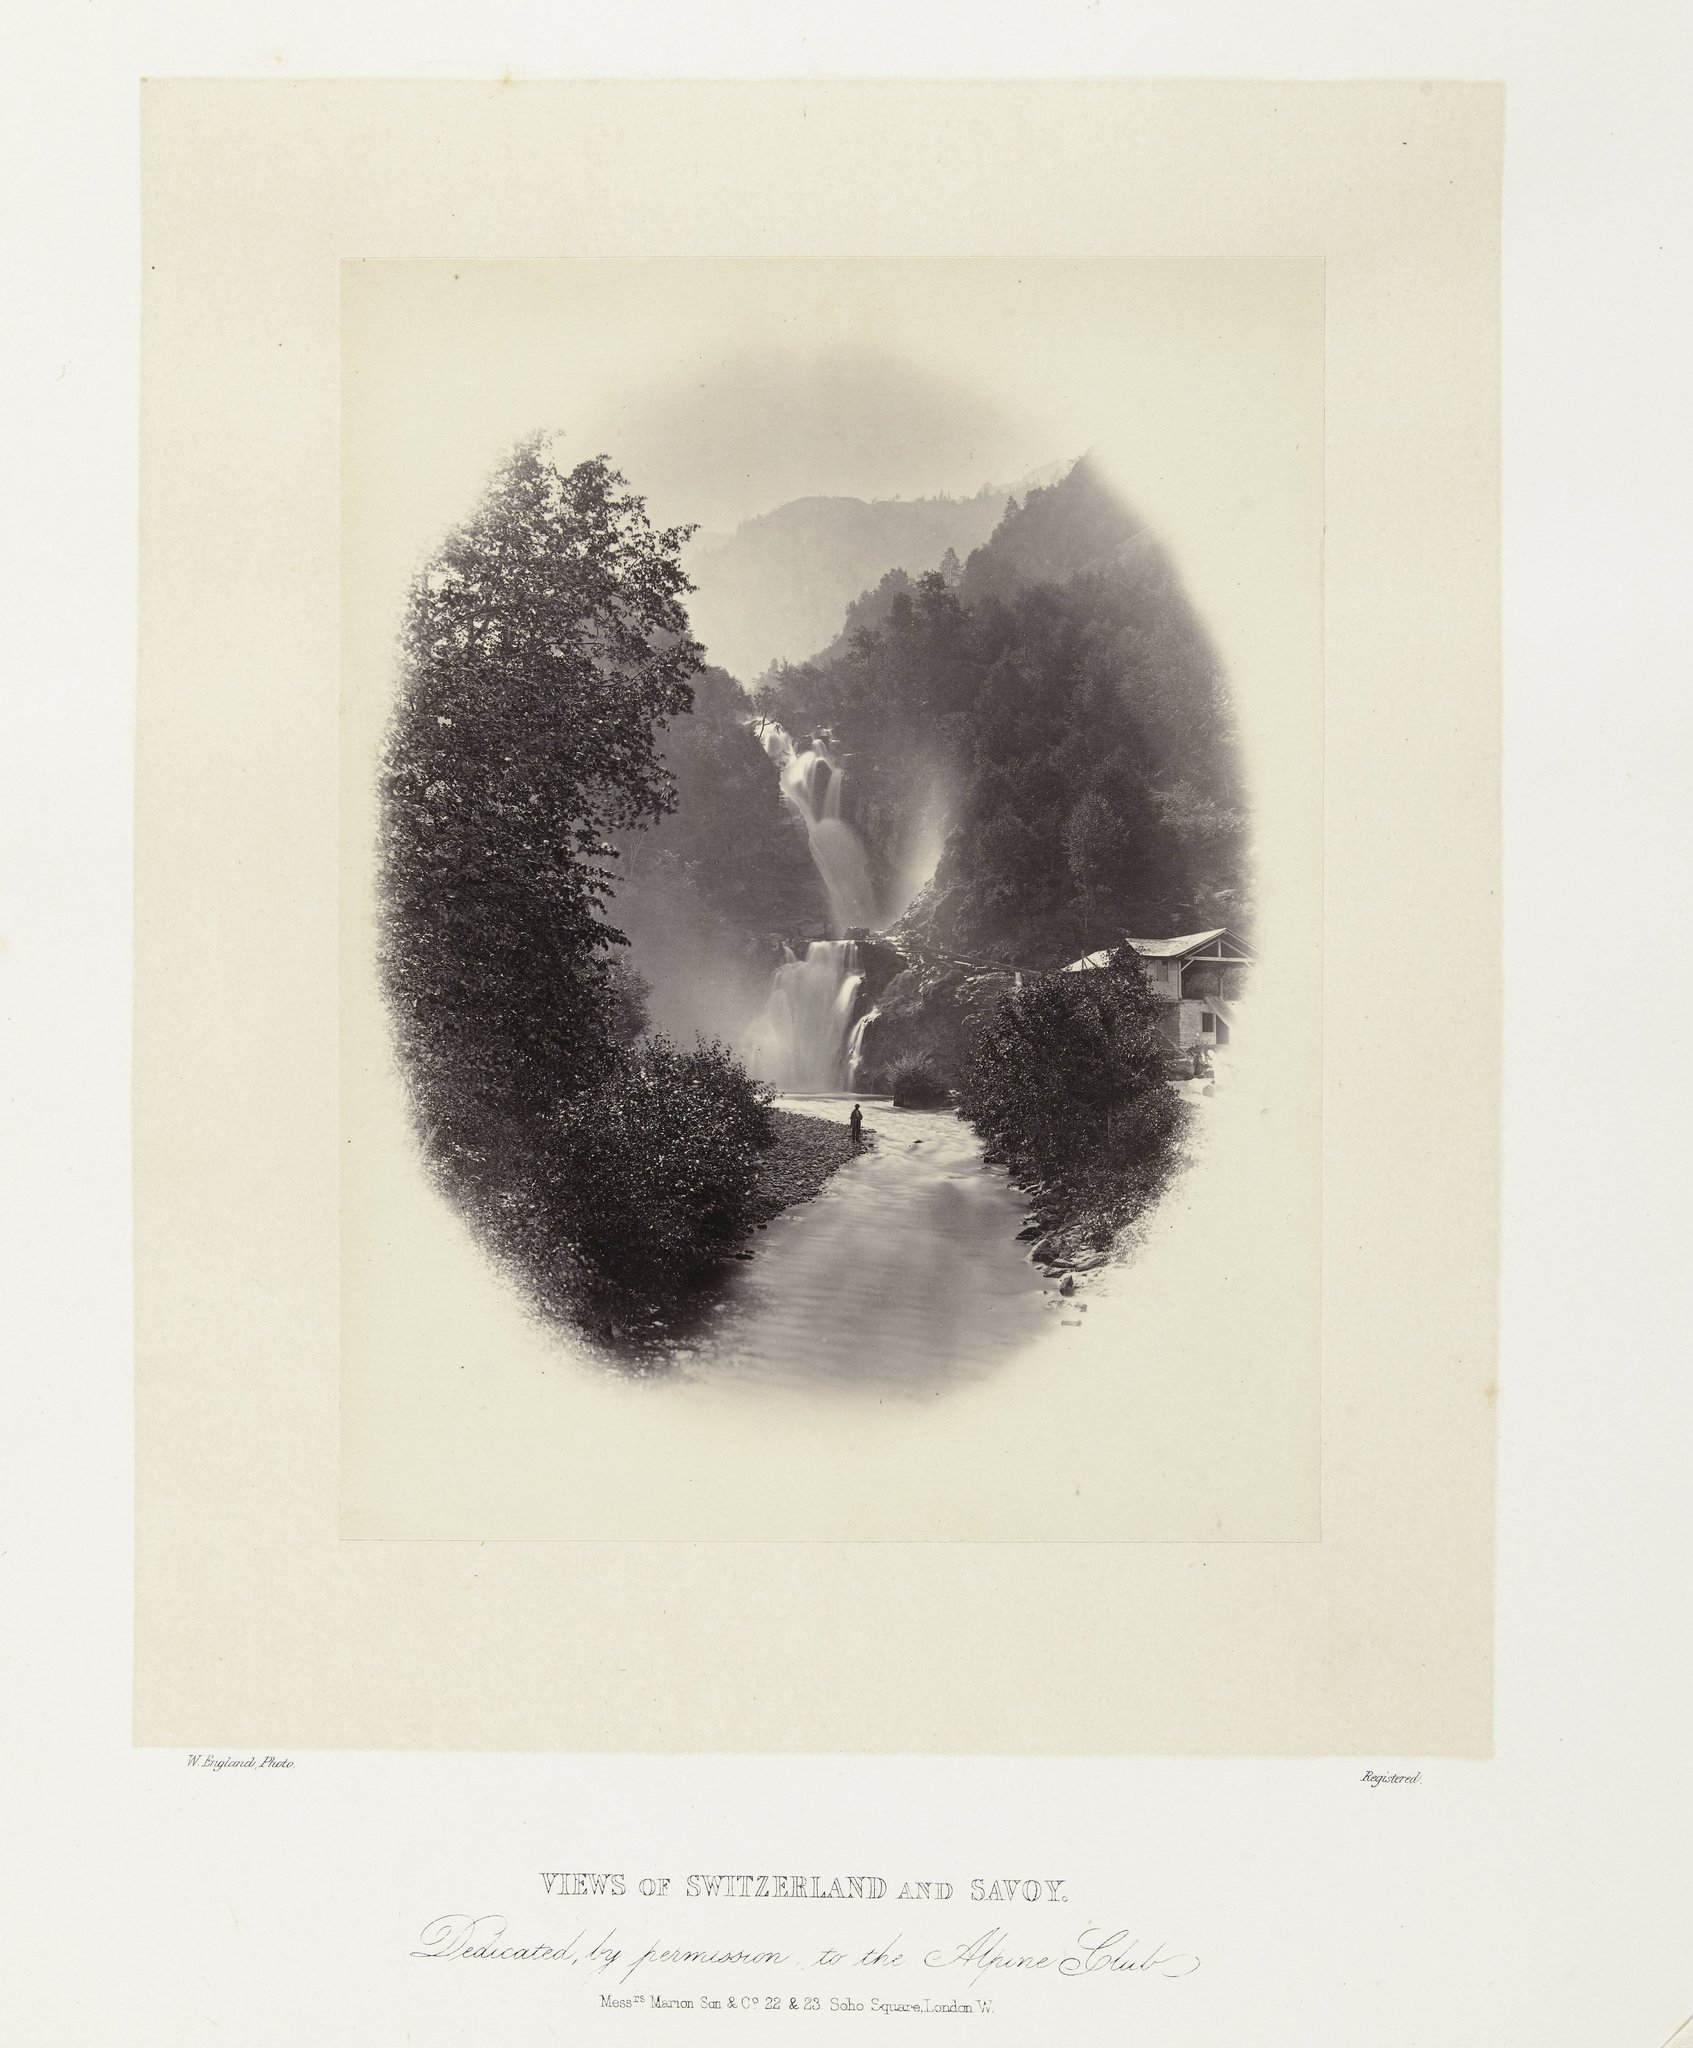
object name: photograph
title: Views of Switzerland and Savoy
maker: william england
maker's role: fotograaf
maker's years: 1816-1896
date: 1863-1865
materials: cardboard, paper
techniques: albumen print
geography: bern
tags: waterfall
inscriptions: inscription: ‘Dedicated, by permission, to the Alpine Club’, address: ‘Messrs Marion & Co 22 & 23 Soho Square, London W.’, inscription: ‘Registered.’